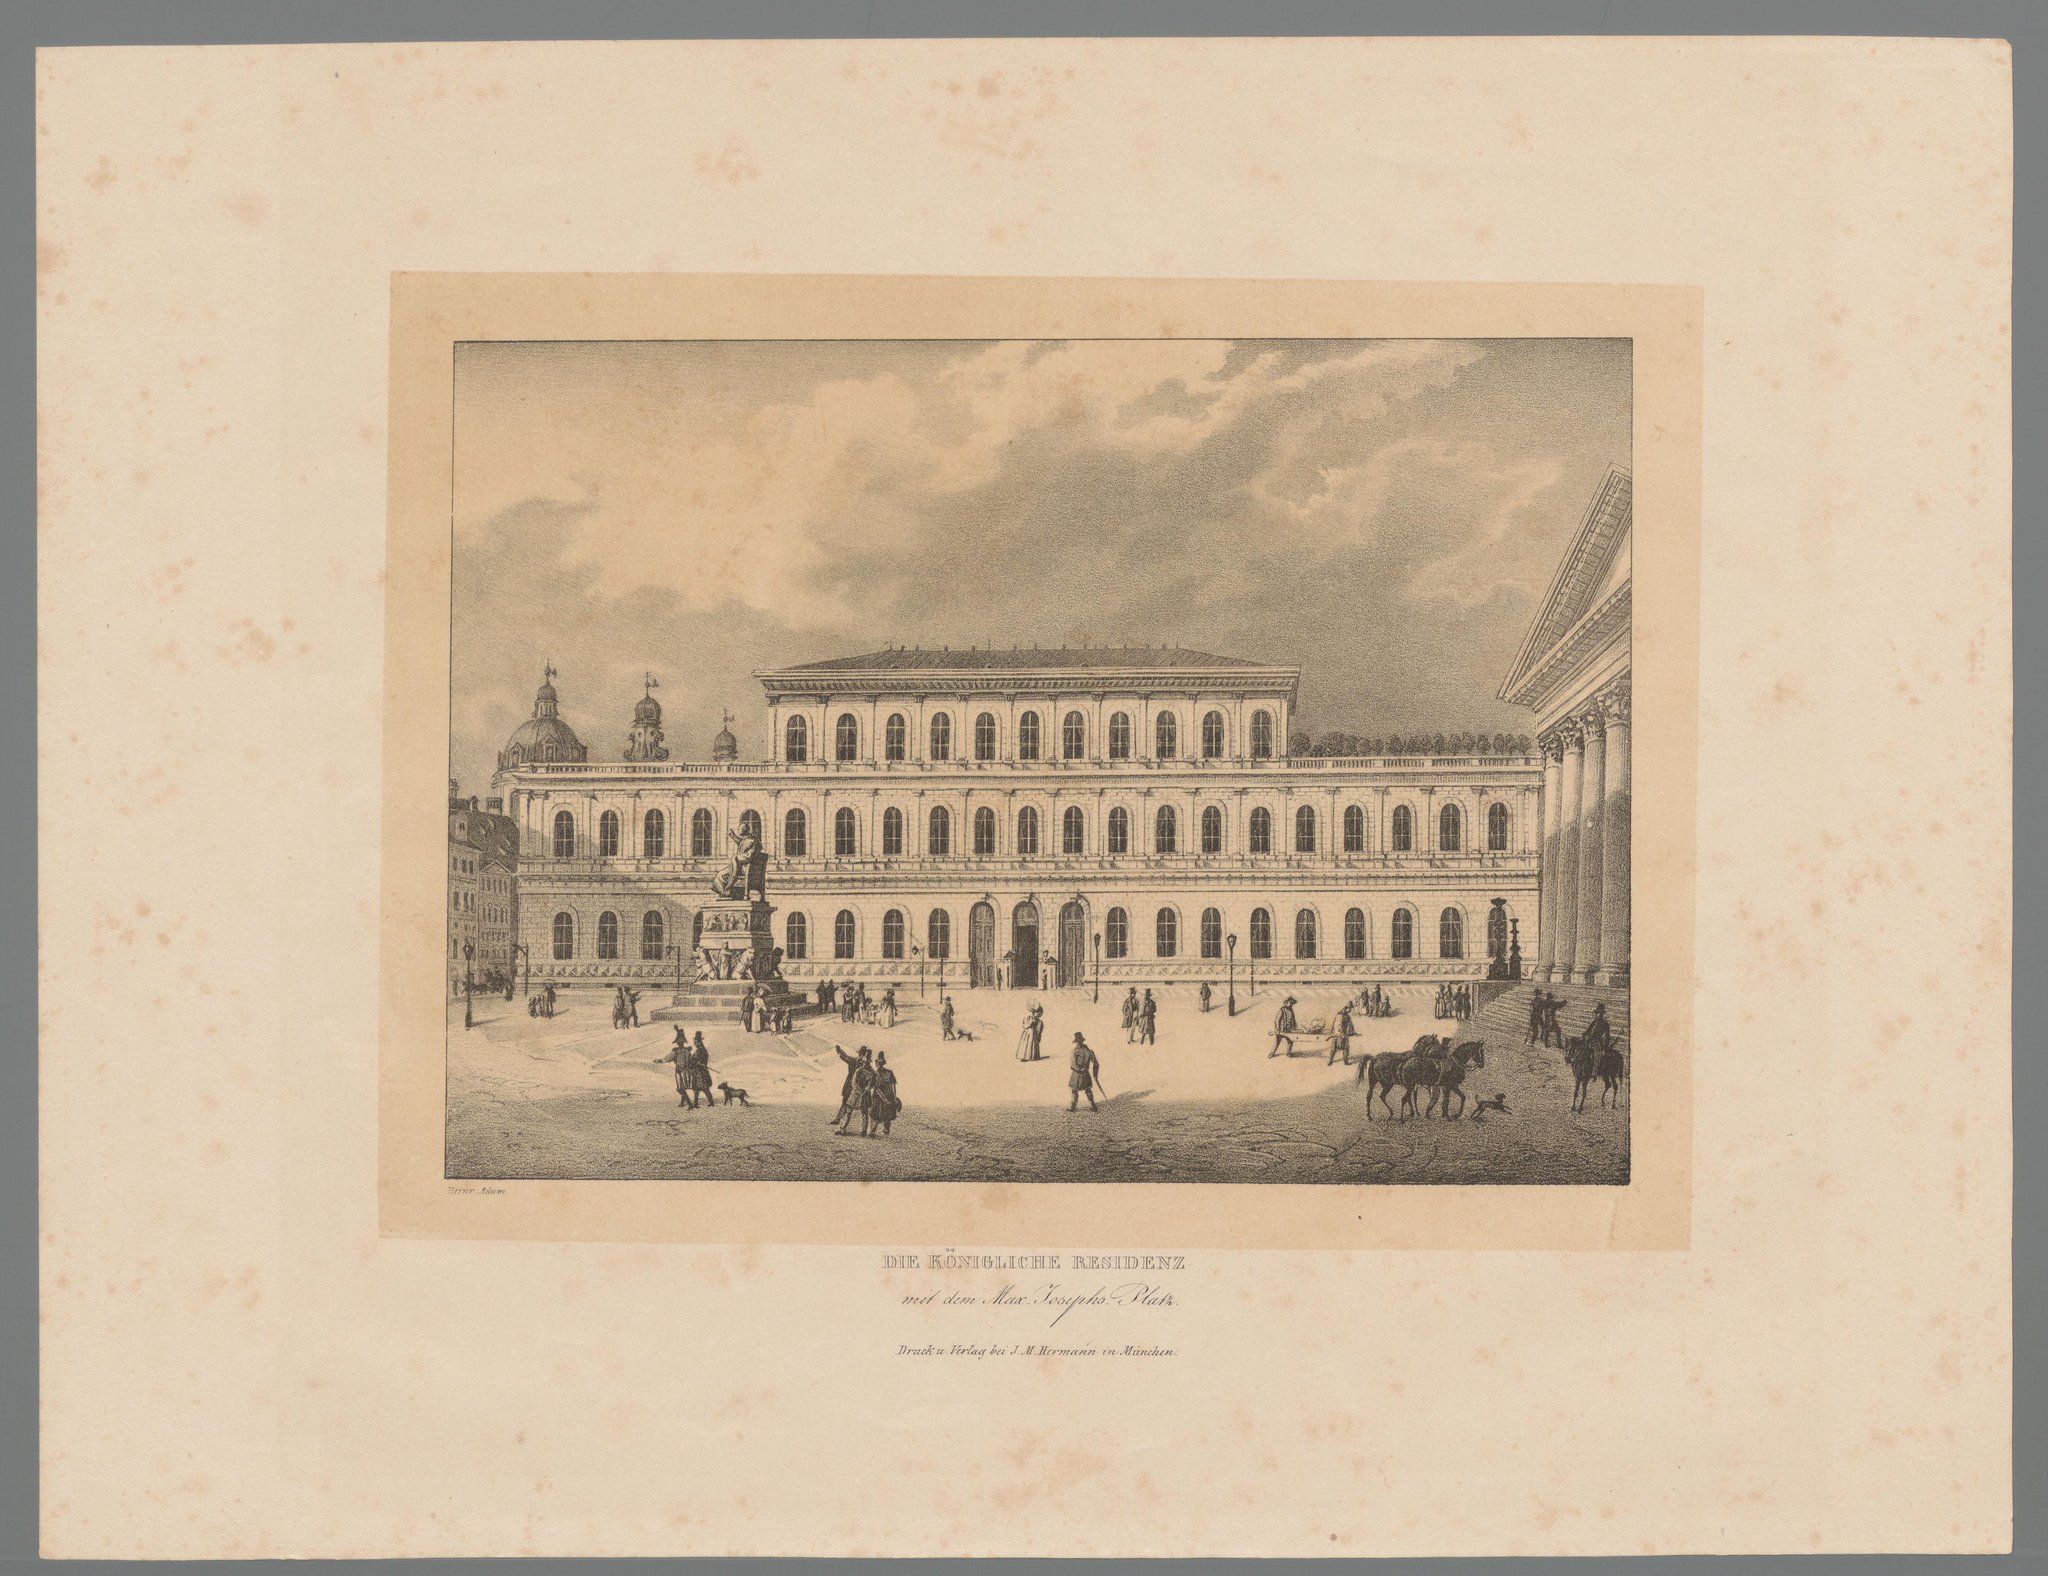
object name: print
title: Gezicht op de Residentie van München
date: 1797-1862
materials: paper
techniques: lithograph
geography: munich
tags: city-view in general; 'veduta', palace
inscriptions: collector's mark: Lugt 2228